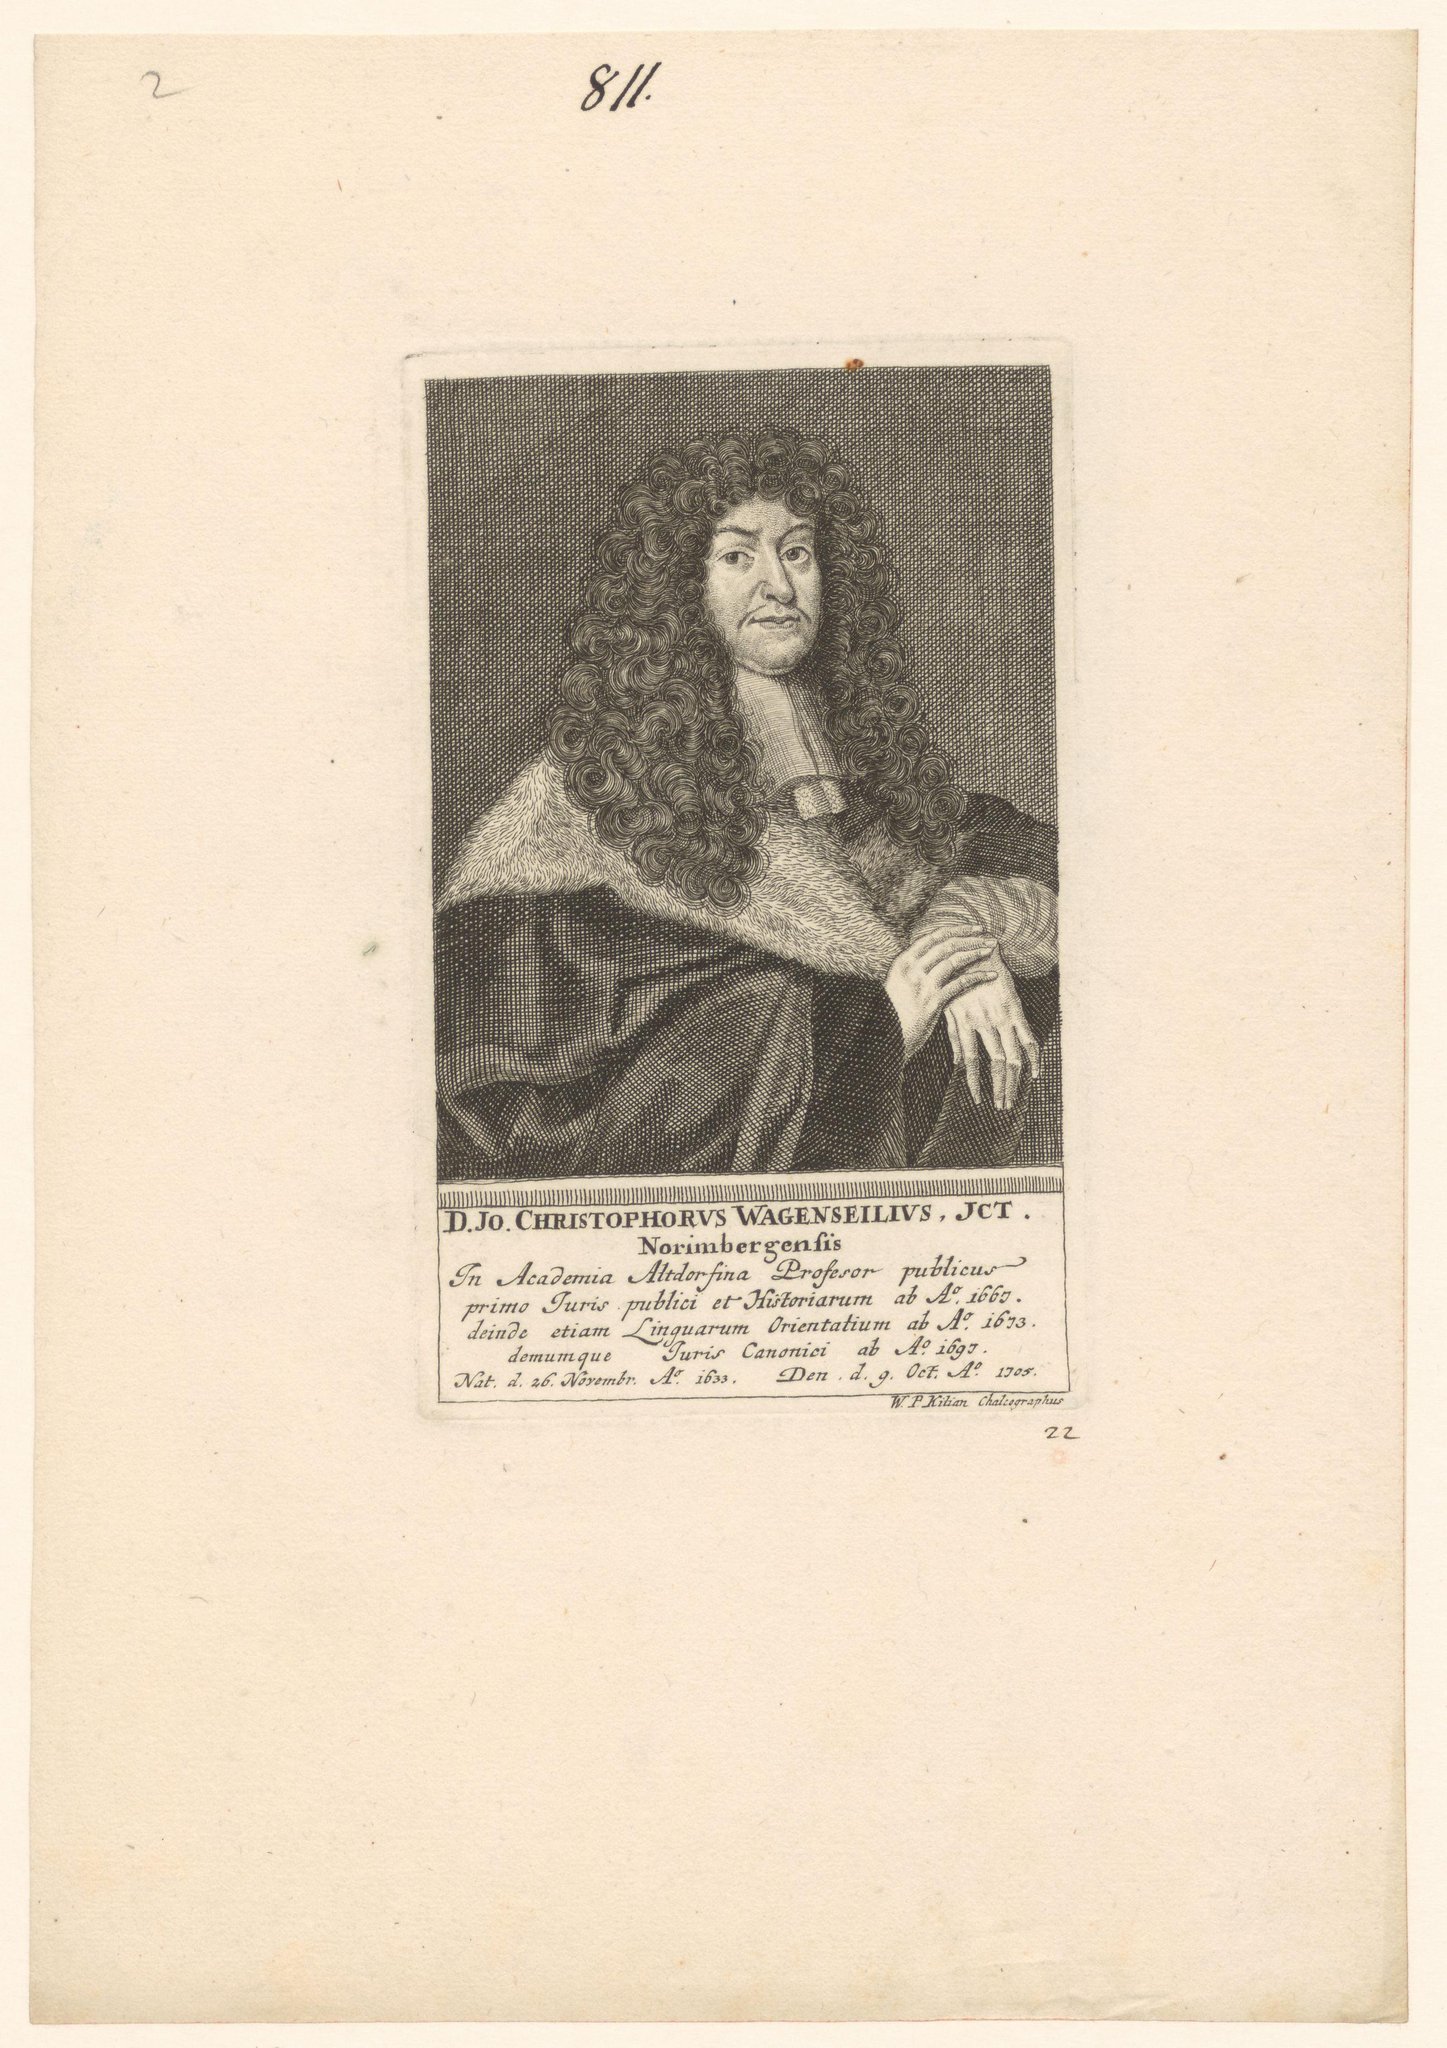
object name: print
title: Portret van Johann Christoph Wagenseil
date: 1705-1732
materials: paper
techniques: engraving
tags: language ~ philology (+ portrait of scholar, scientist), further education (+ portrait of teacher, professor), historical persons, lawyer, attorney at law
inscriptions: number: ‘22’, collector's mark: Lugt 2228